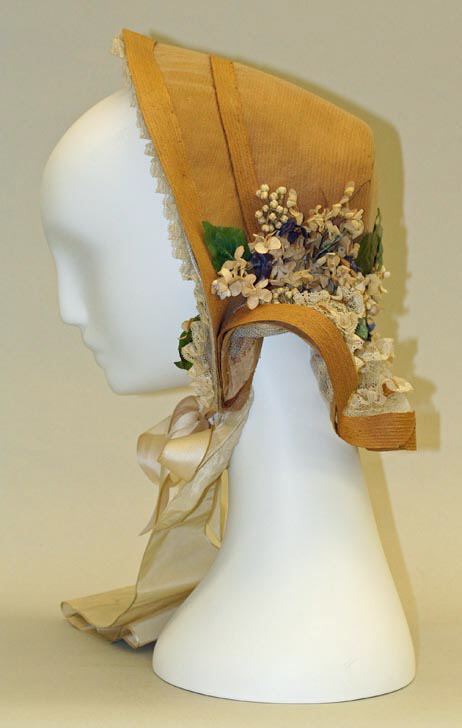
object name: poke bonnet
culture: american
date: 1856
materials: fiber